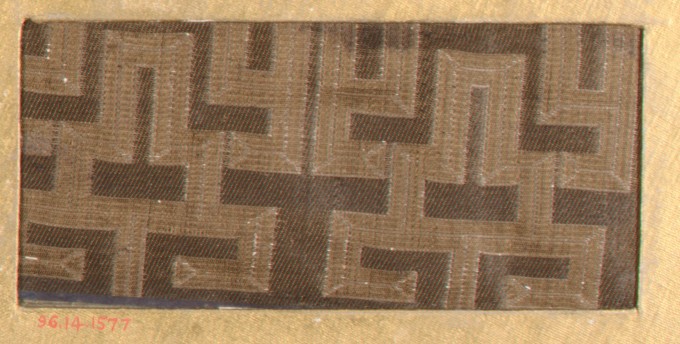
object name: piece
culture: japanese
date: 1701-1900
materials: silk